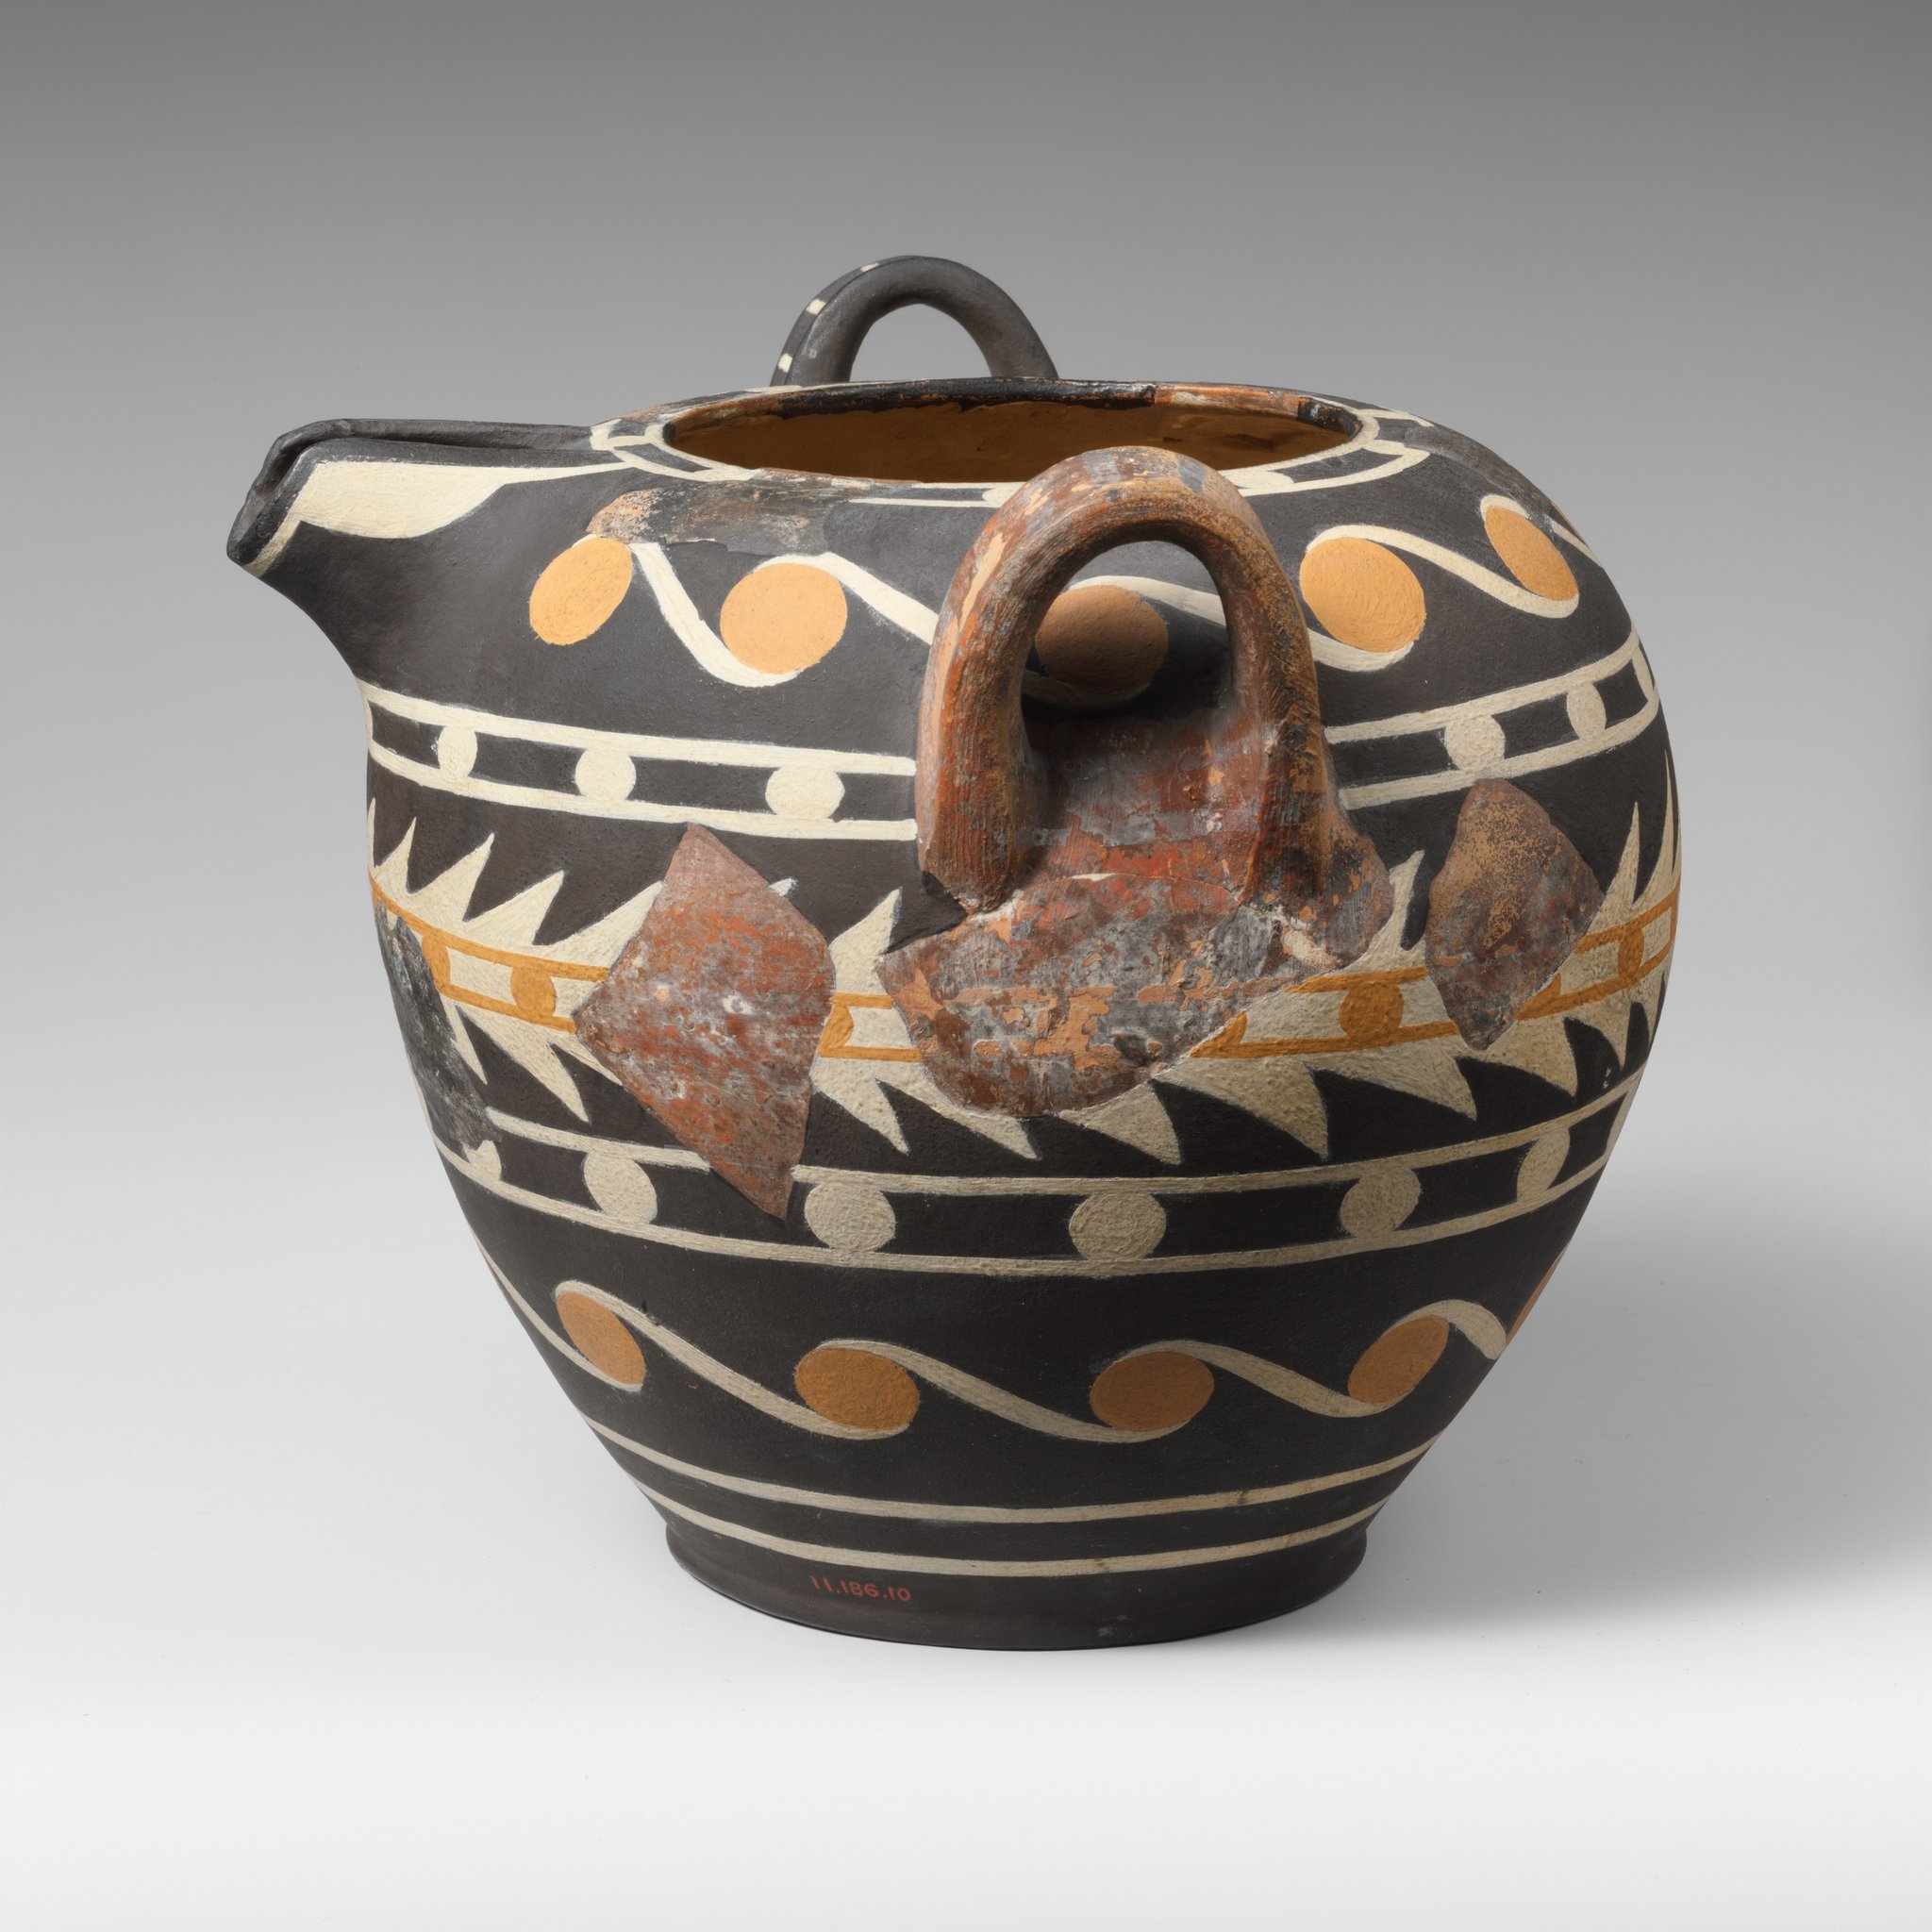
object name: jar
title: Terracotta bridge-spouted jar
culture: minoan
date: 1900-1600 BCE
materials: terracotta